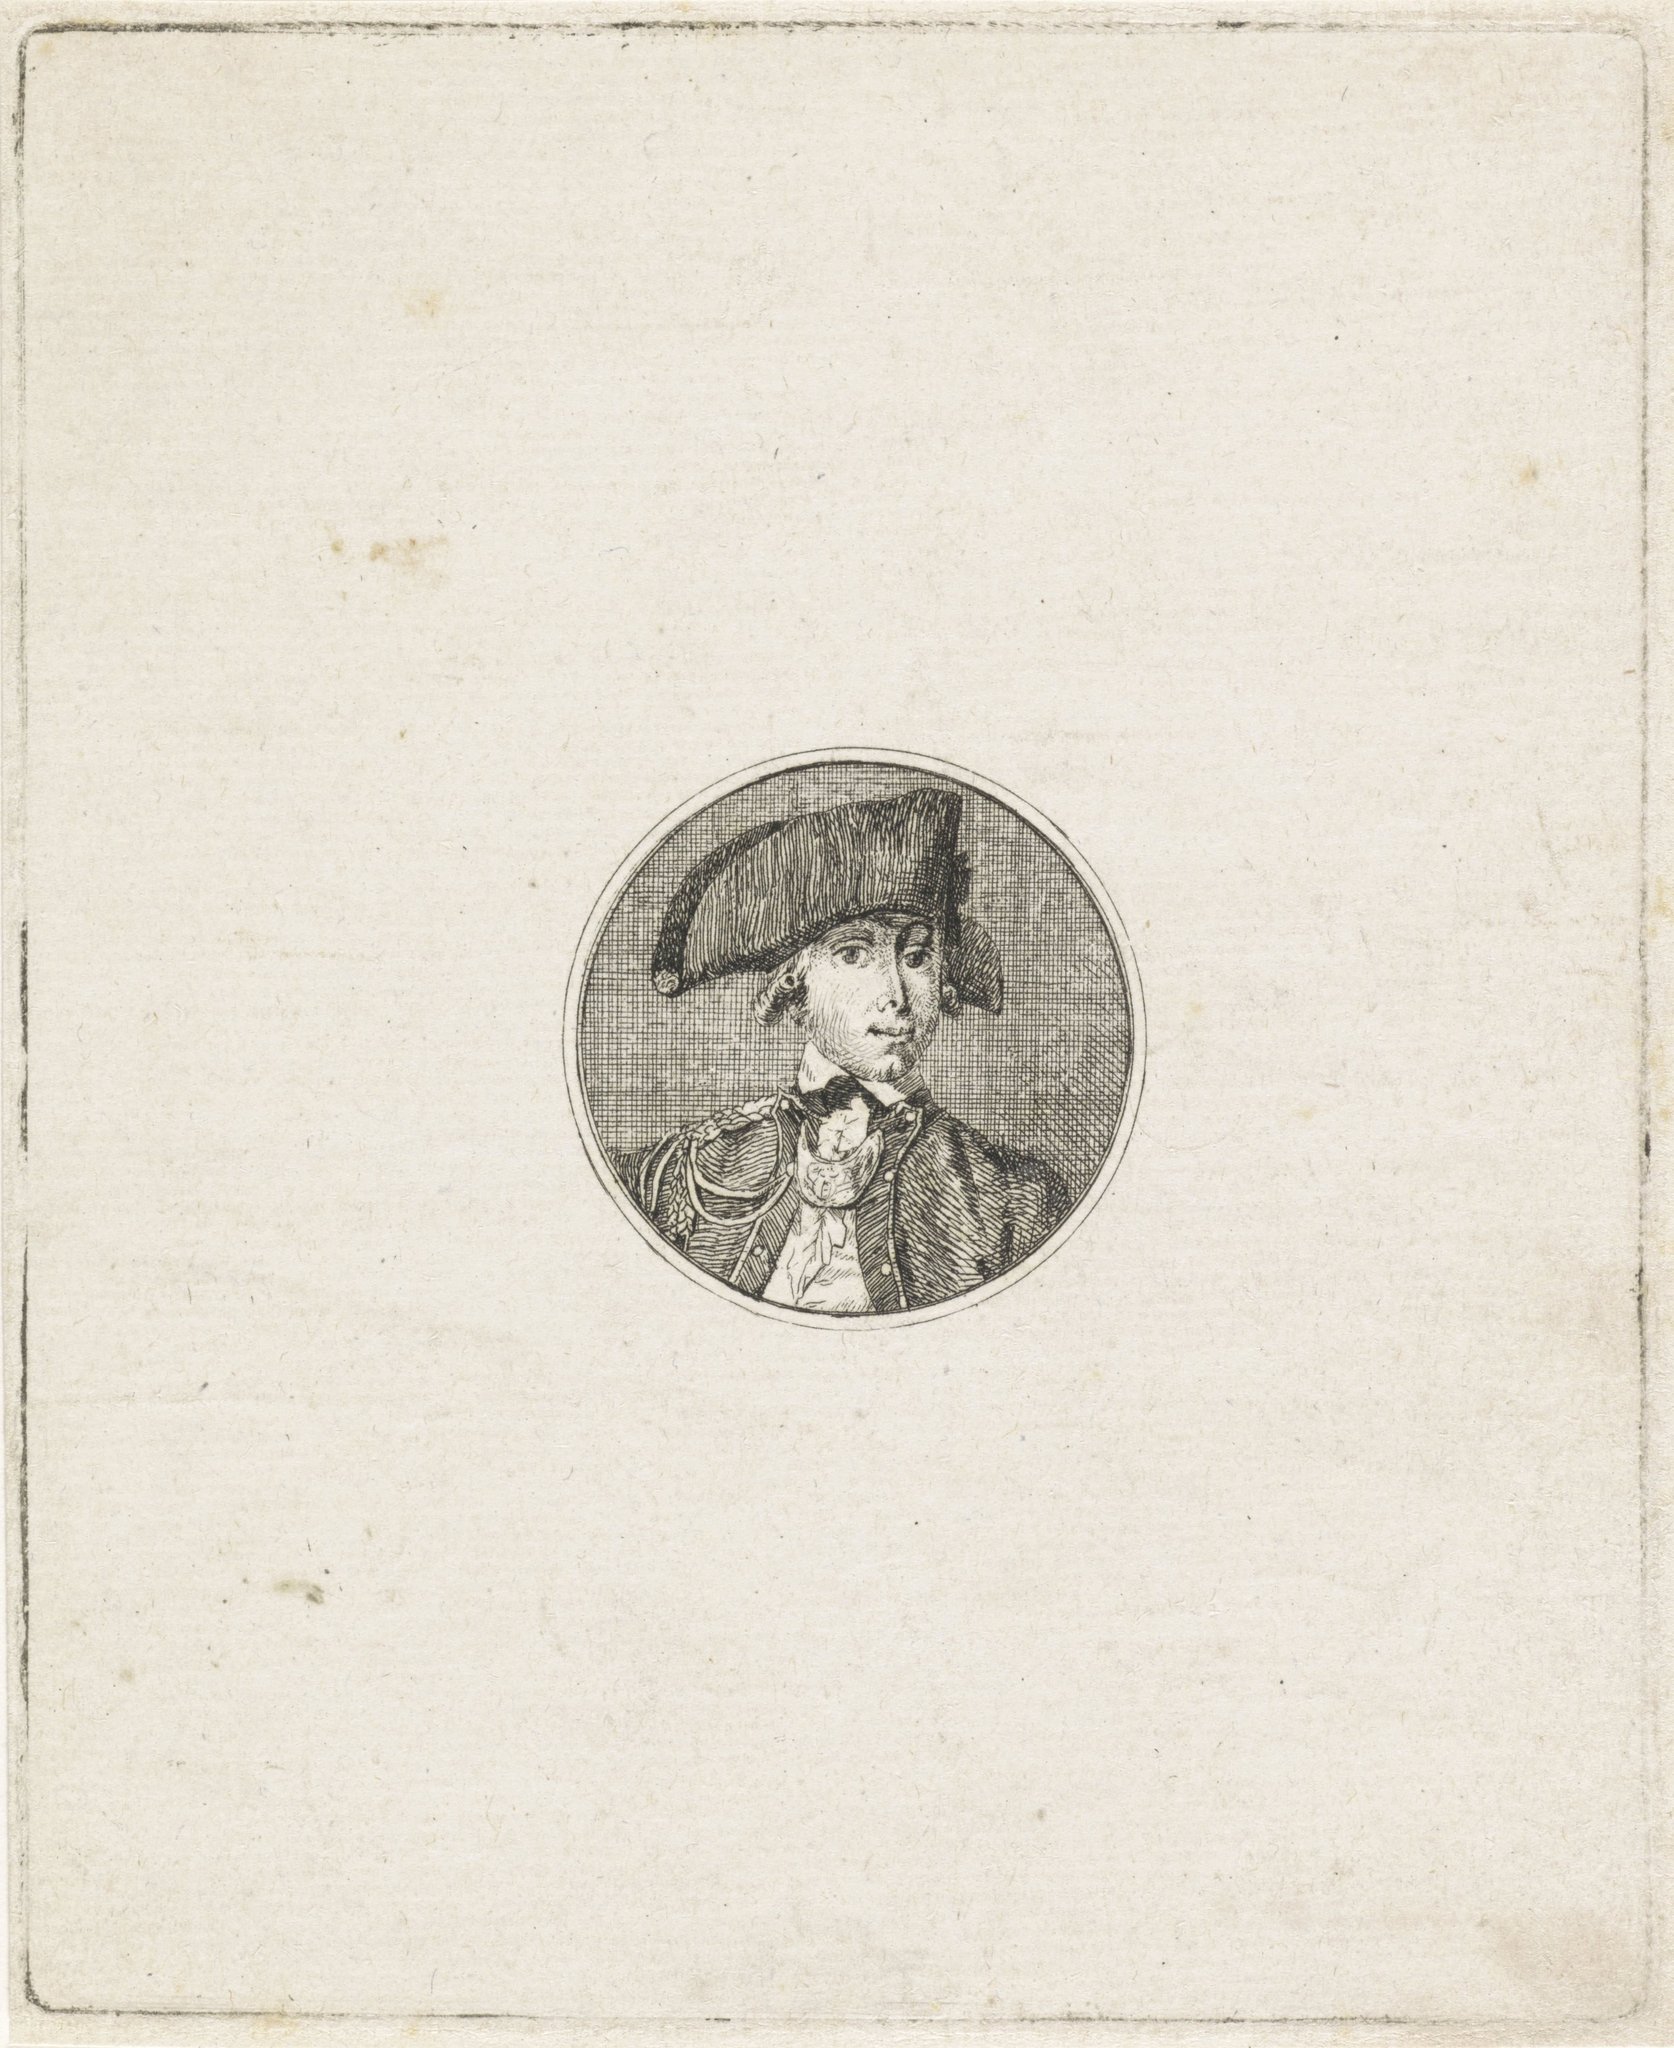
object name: print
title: Portret van Abraham Valentijn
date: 1787-1815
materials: paper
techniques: etching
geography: amsterdam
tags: historical persons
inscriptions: collector's mark: Lugt 2228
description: Buste van de patriot Abraham Valentijn naar rechts in een medaillon. Hij draagt een steek.